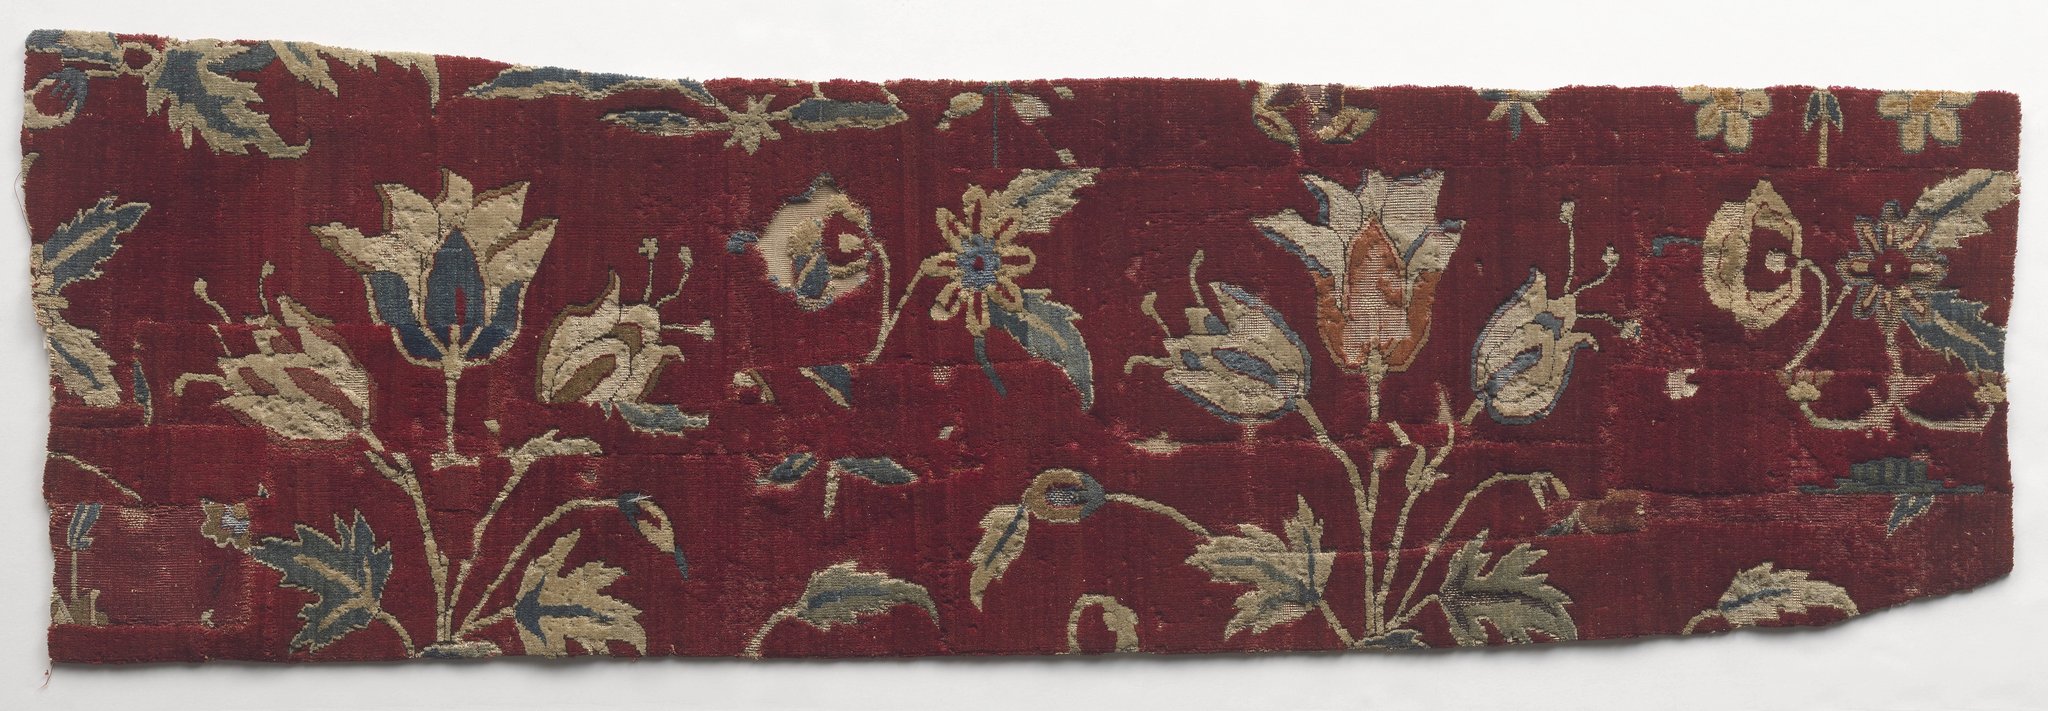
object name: tapijt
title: Fragment van een tapijt, uit negentien delen samengesteld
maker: Anonymous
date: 1640-1650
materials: cotton, wool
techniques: senneh knot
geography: north india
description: Fragment van een tapijt, uit negentien delen samengesteld. Bloemenmotief.